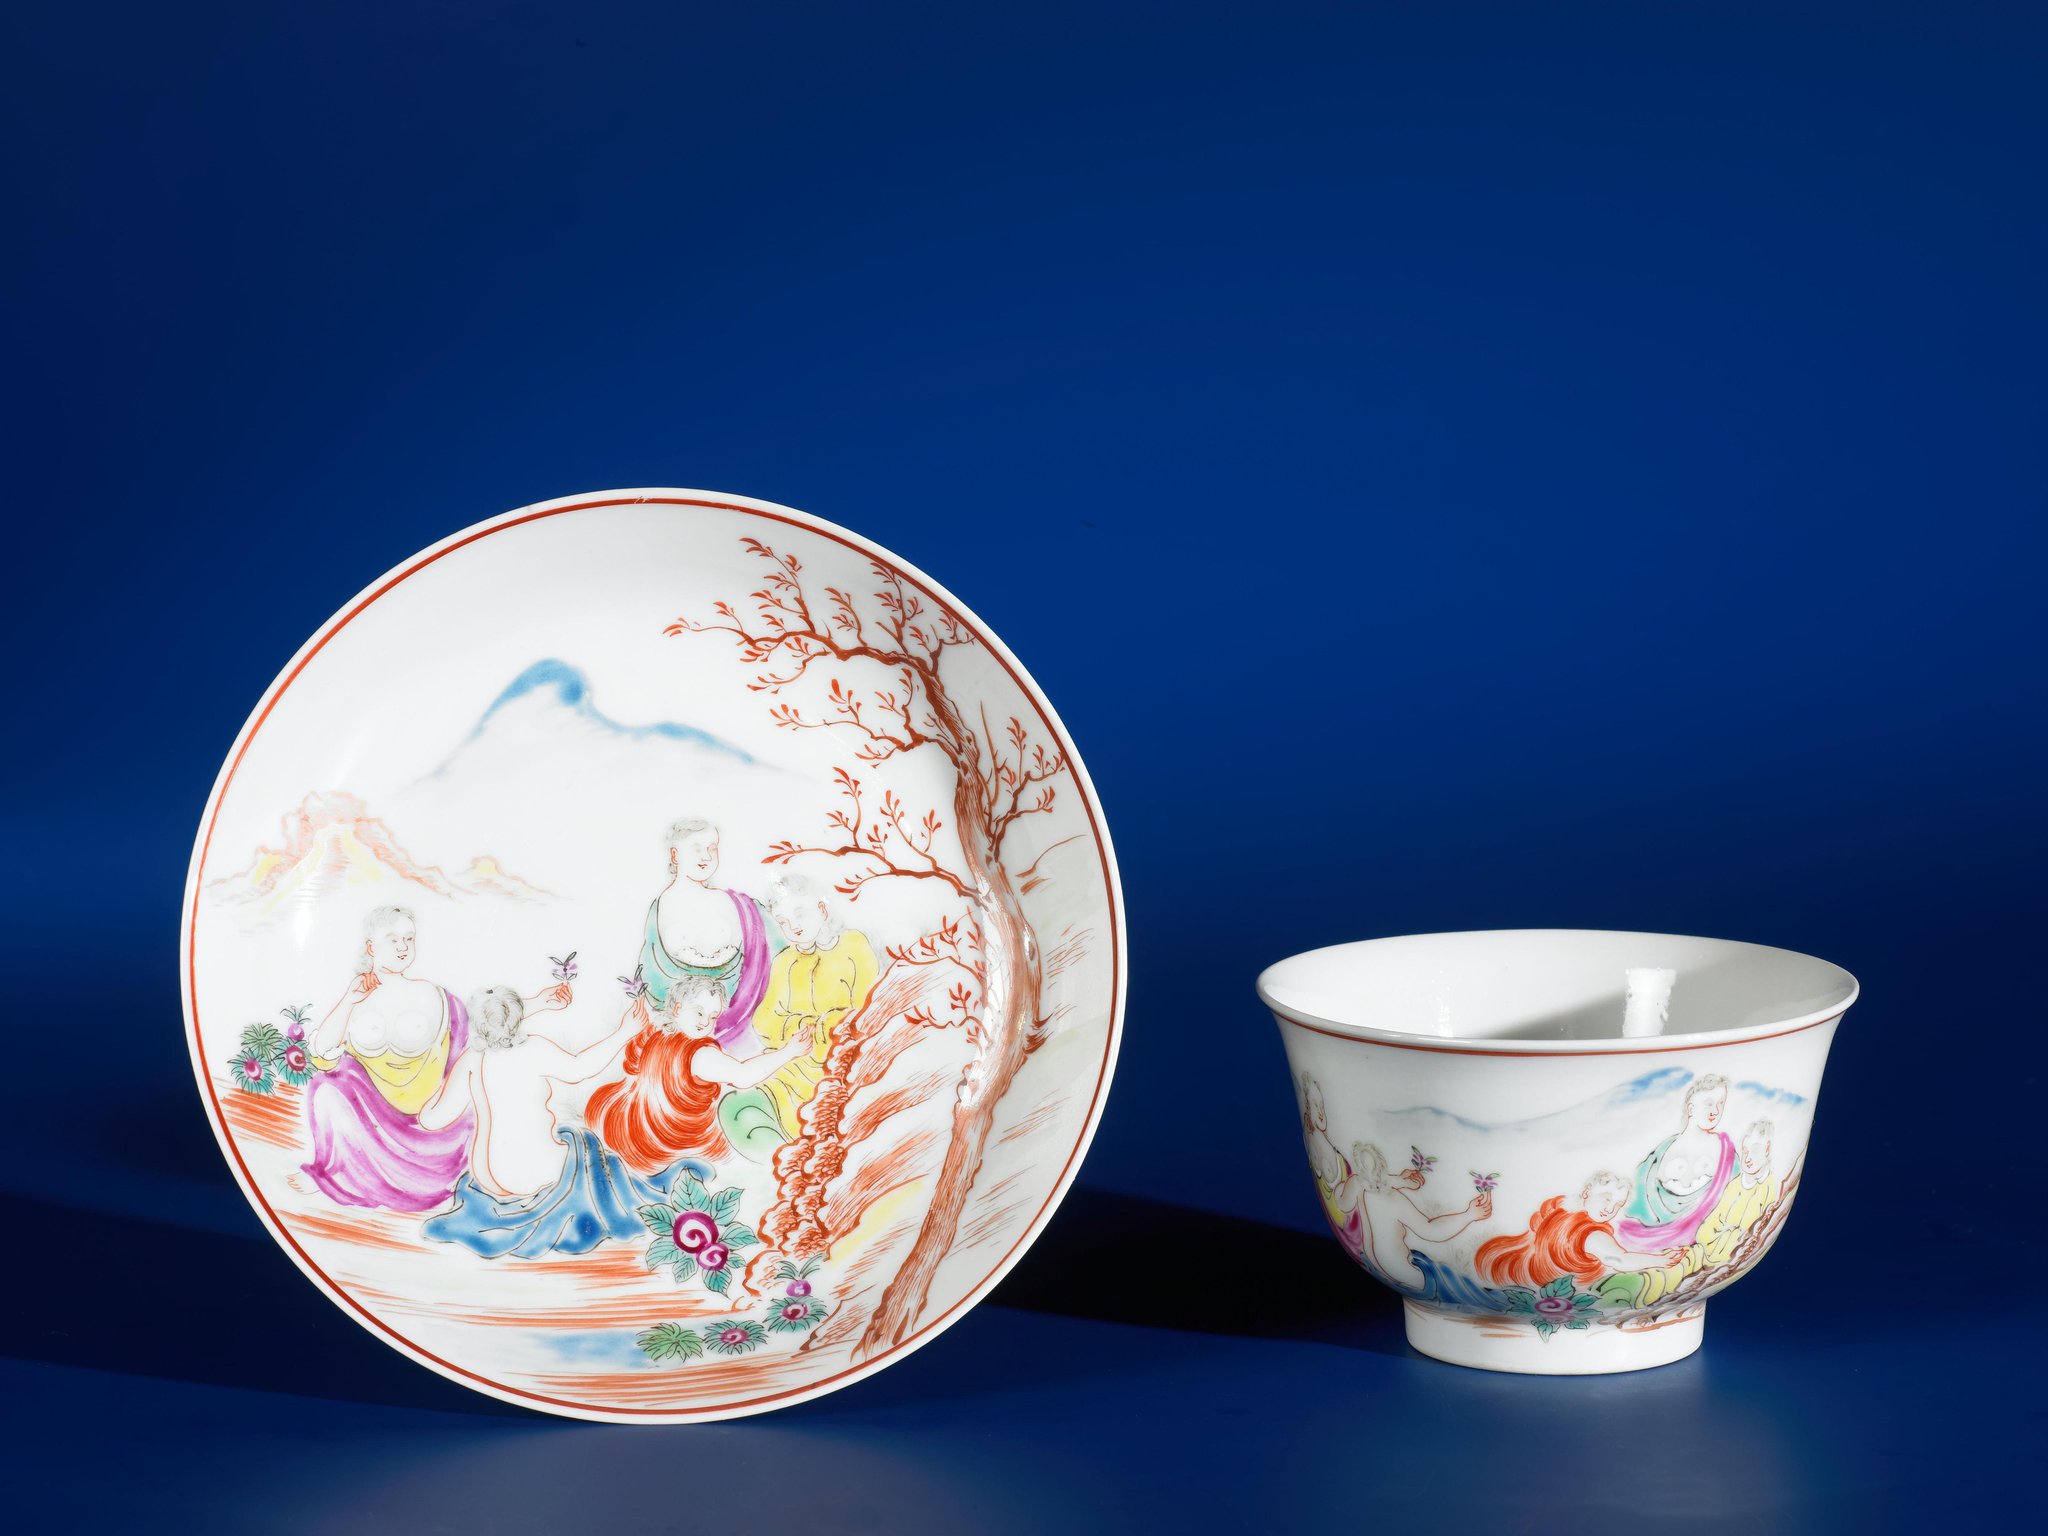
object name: kop en schotel, kop en schotel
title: Bell-shaped cup with European figures in a landscape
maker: Anonymous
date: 1750-1774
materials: glaze, paint, porcelain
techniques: firing, turning, vitrification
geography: china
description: Wijd uitlopende kop op een hoge voetring en schotel op een voetring. Gedecoreerd in emailkleuren met drie figuren in klassieke gewaden in een landschap. De betekenis van de voorstelling is onduidelijk, ook al heeft zeer waarschijnlijk een Europese prent als voorbeeld gediend. Het zou een mythologische voorstelling kunnen zijn. Het Rijksmuseum bezit een bord met dezelfde afbeelding (zie AK-NM-13556). De kwaliteit van het schilderwerk op deze kop en schotel is hoger.